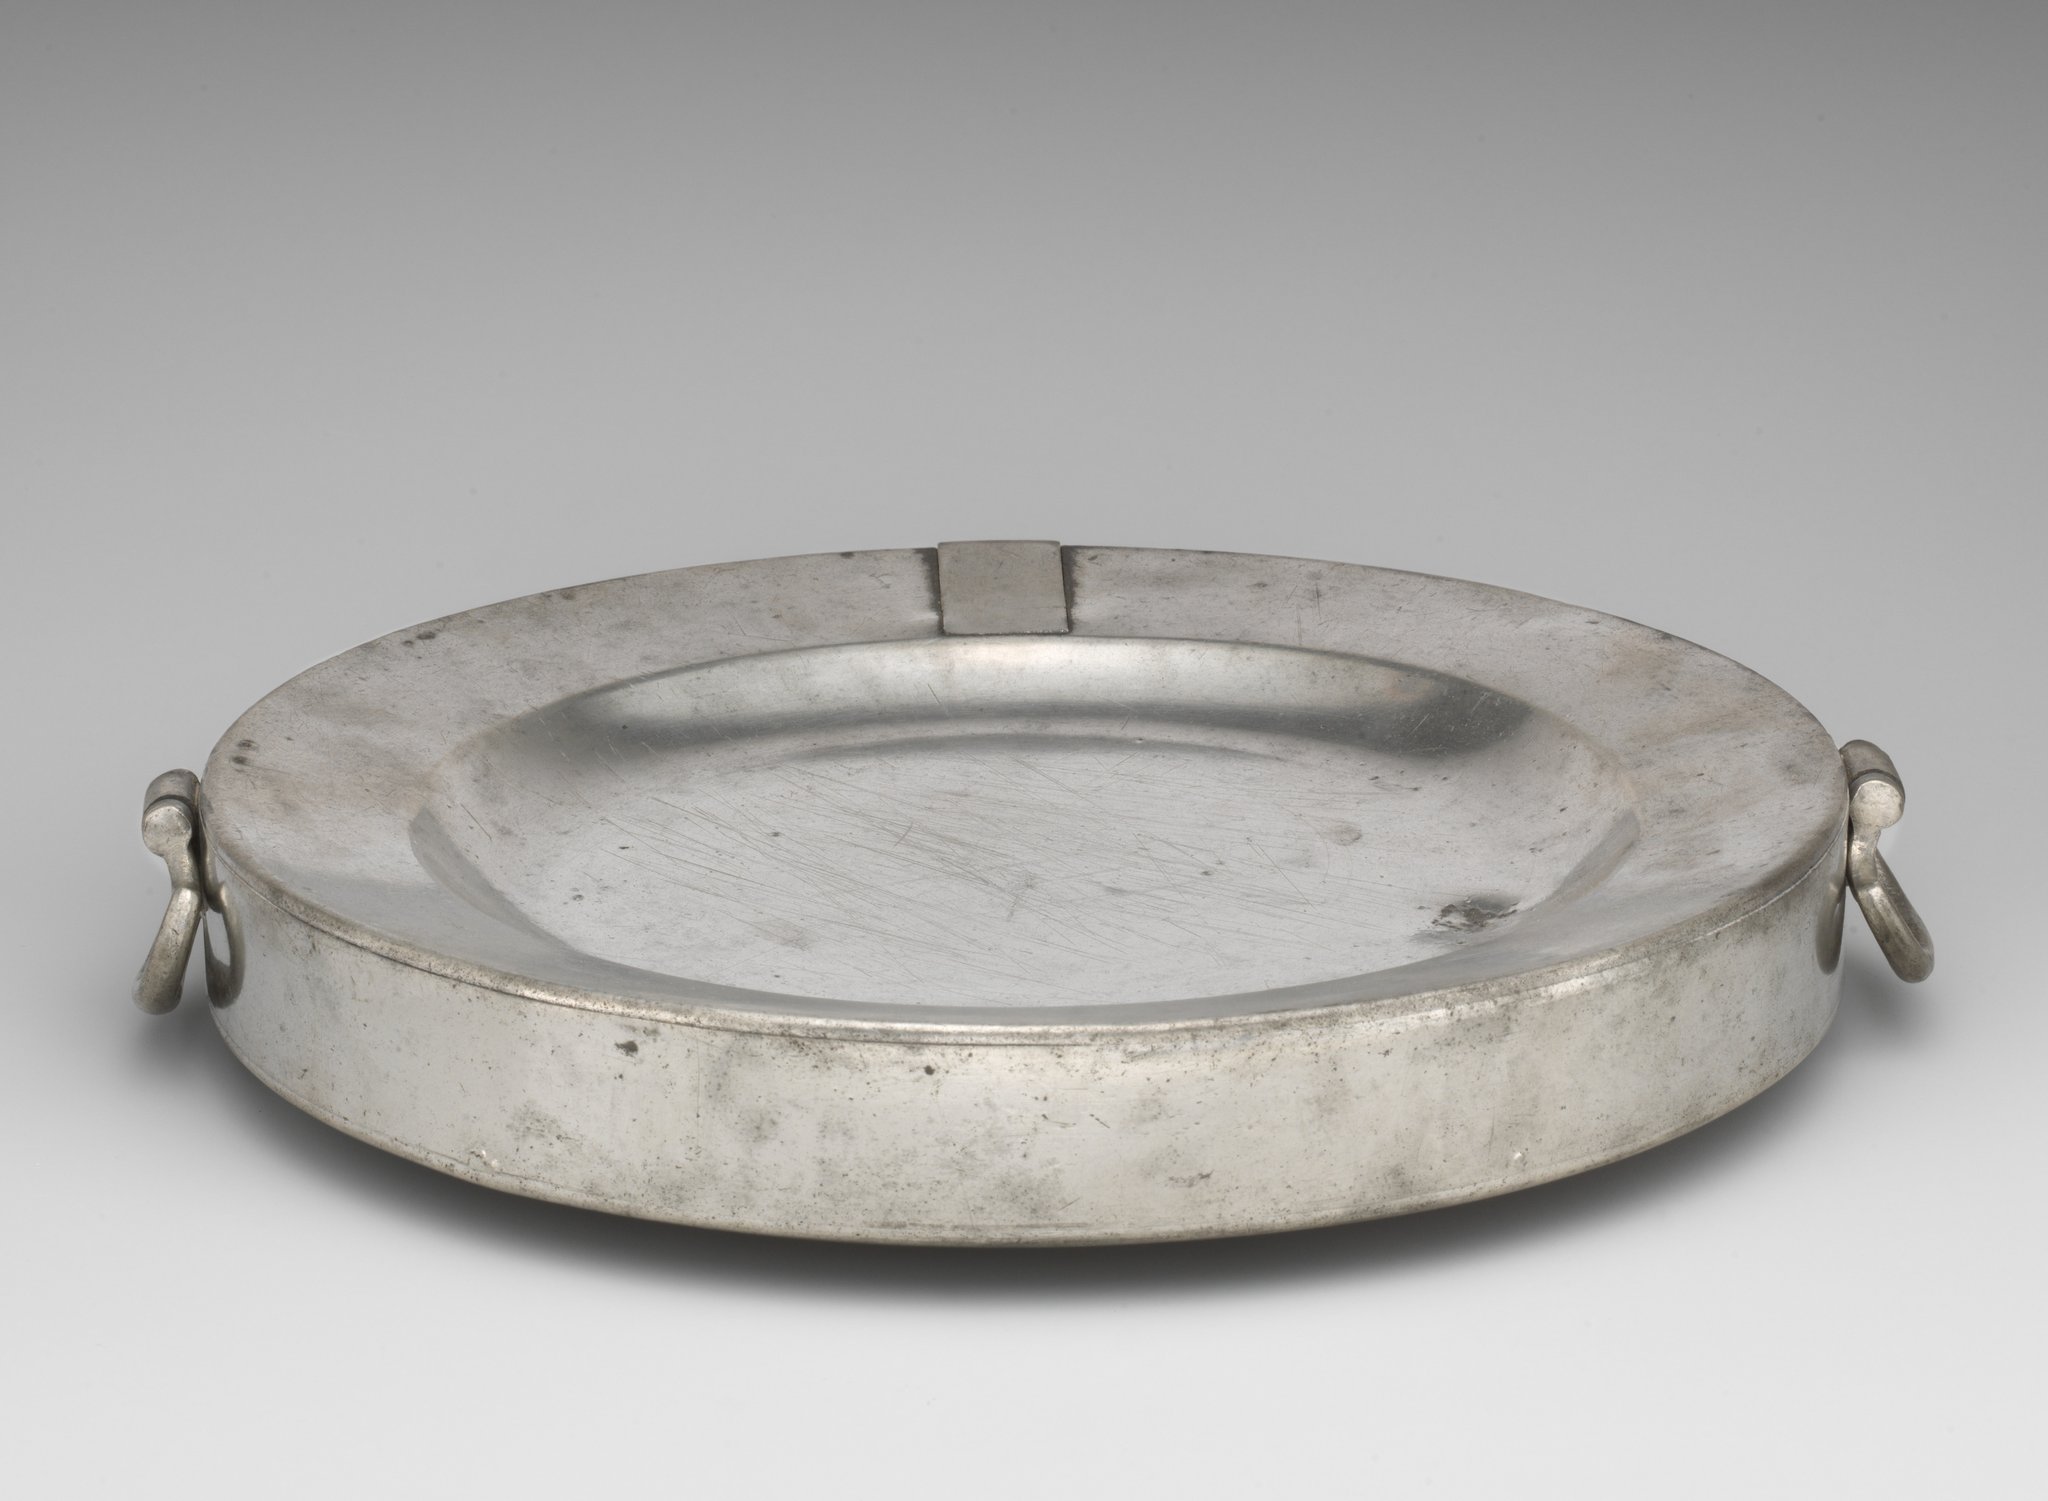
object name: hot water dish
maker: thomas swanson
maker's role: maker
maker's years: 1683-1783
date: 1751-1775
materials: pewter